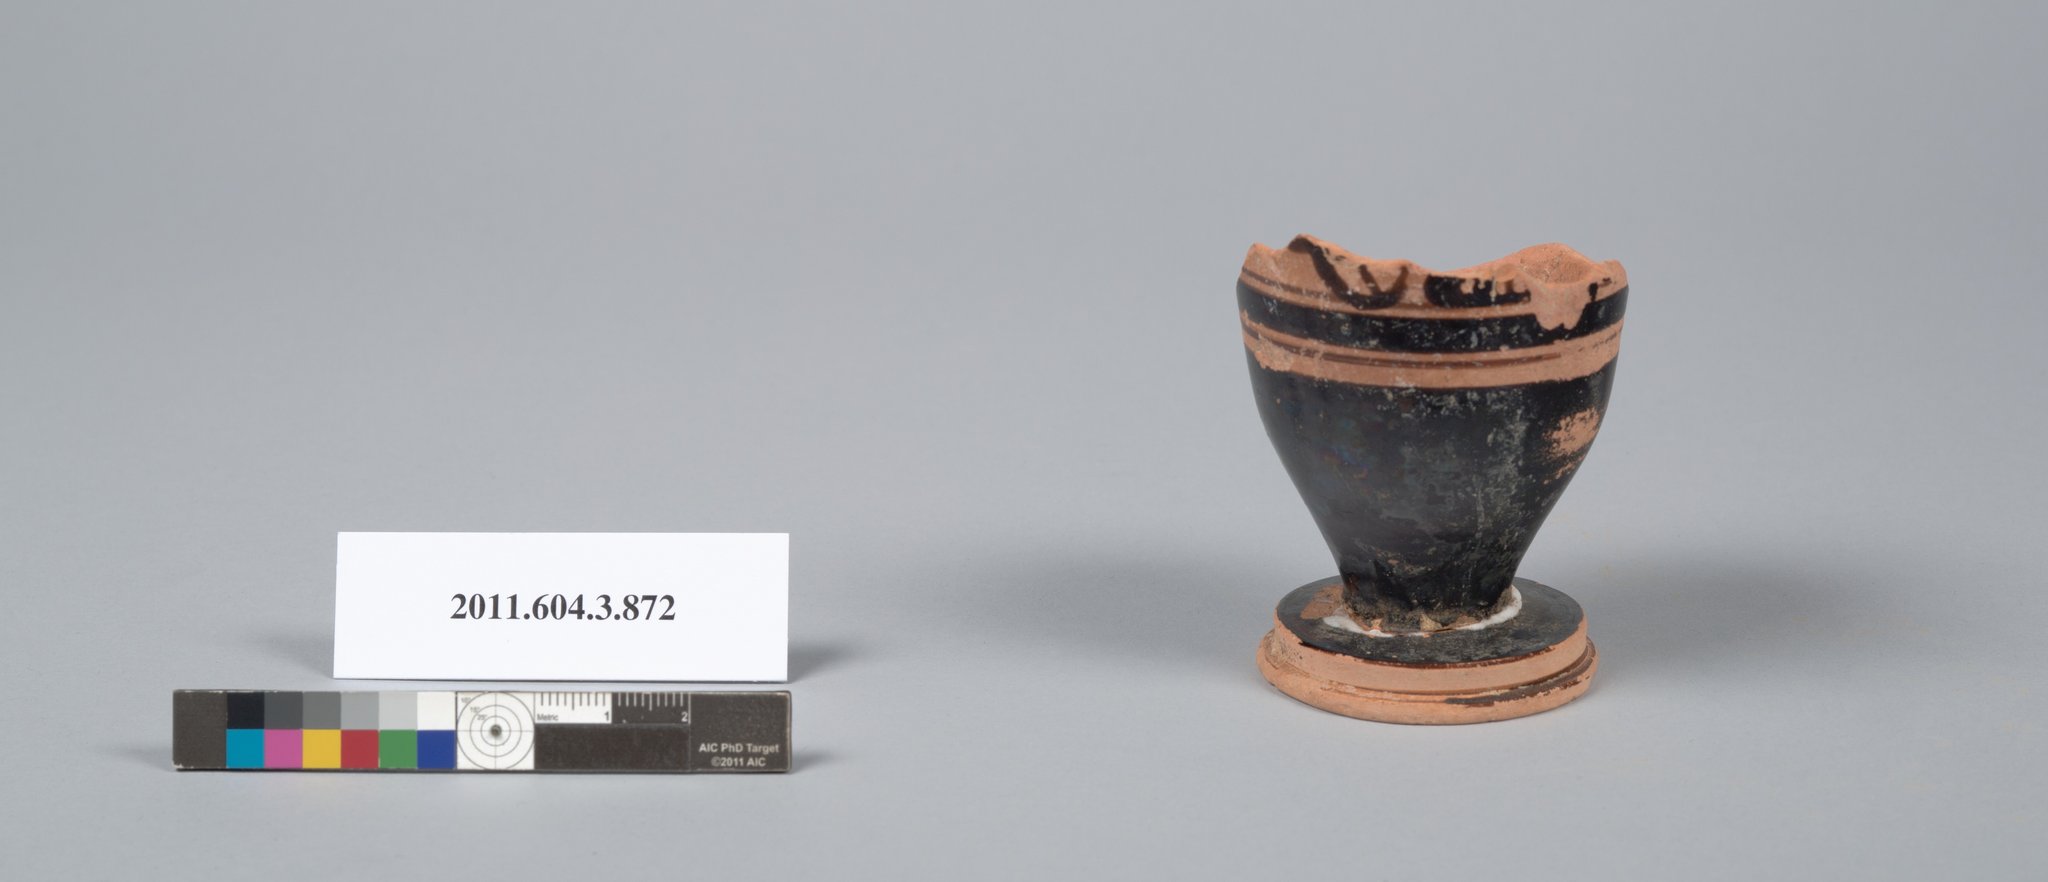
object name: lekythos fragment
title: Terracotta fragment of a lekythos (oil flask)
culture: greek, attic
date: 500-468 BCE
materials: terracotta